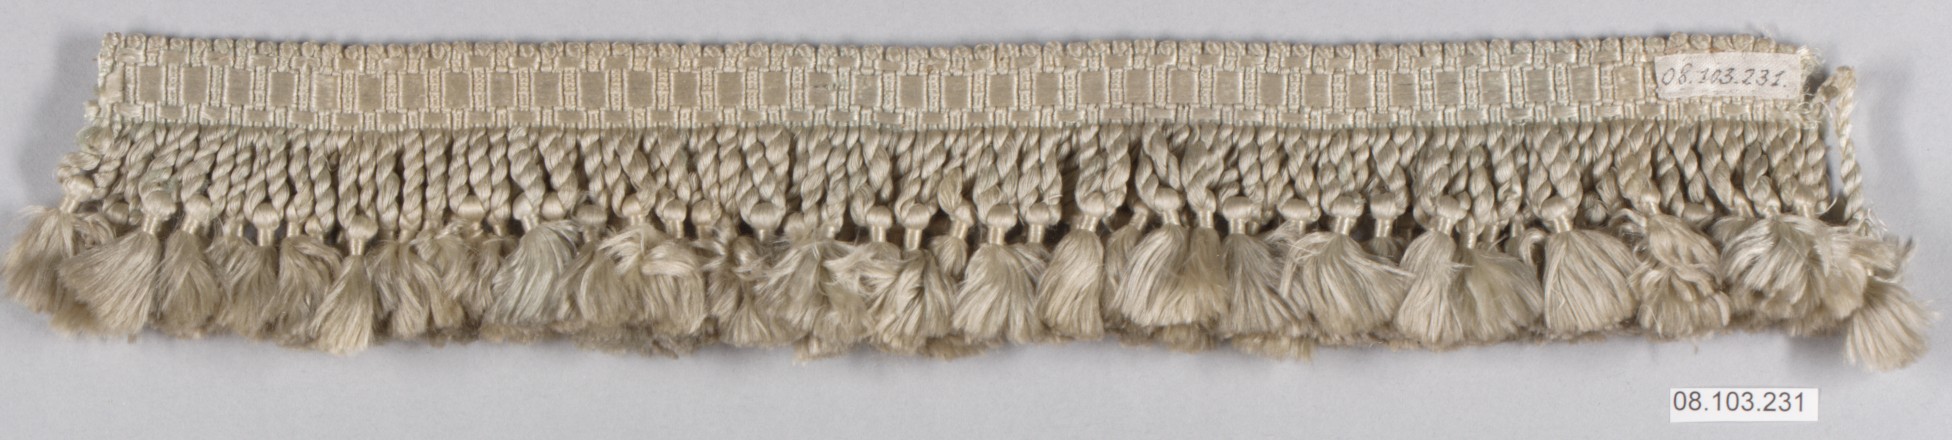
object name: fringe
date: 1801-1900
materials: silk